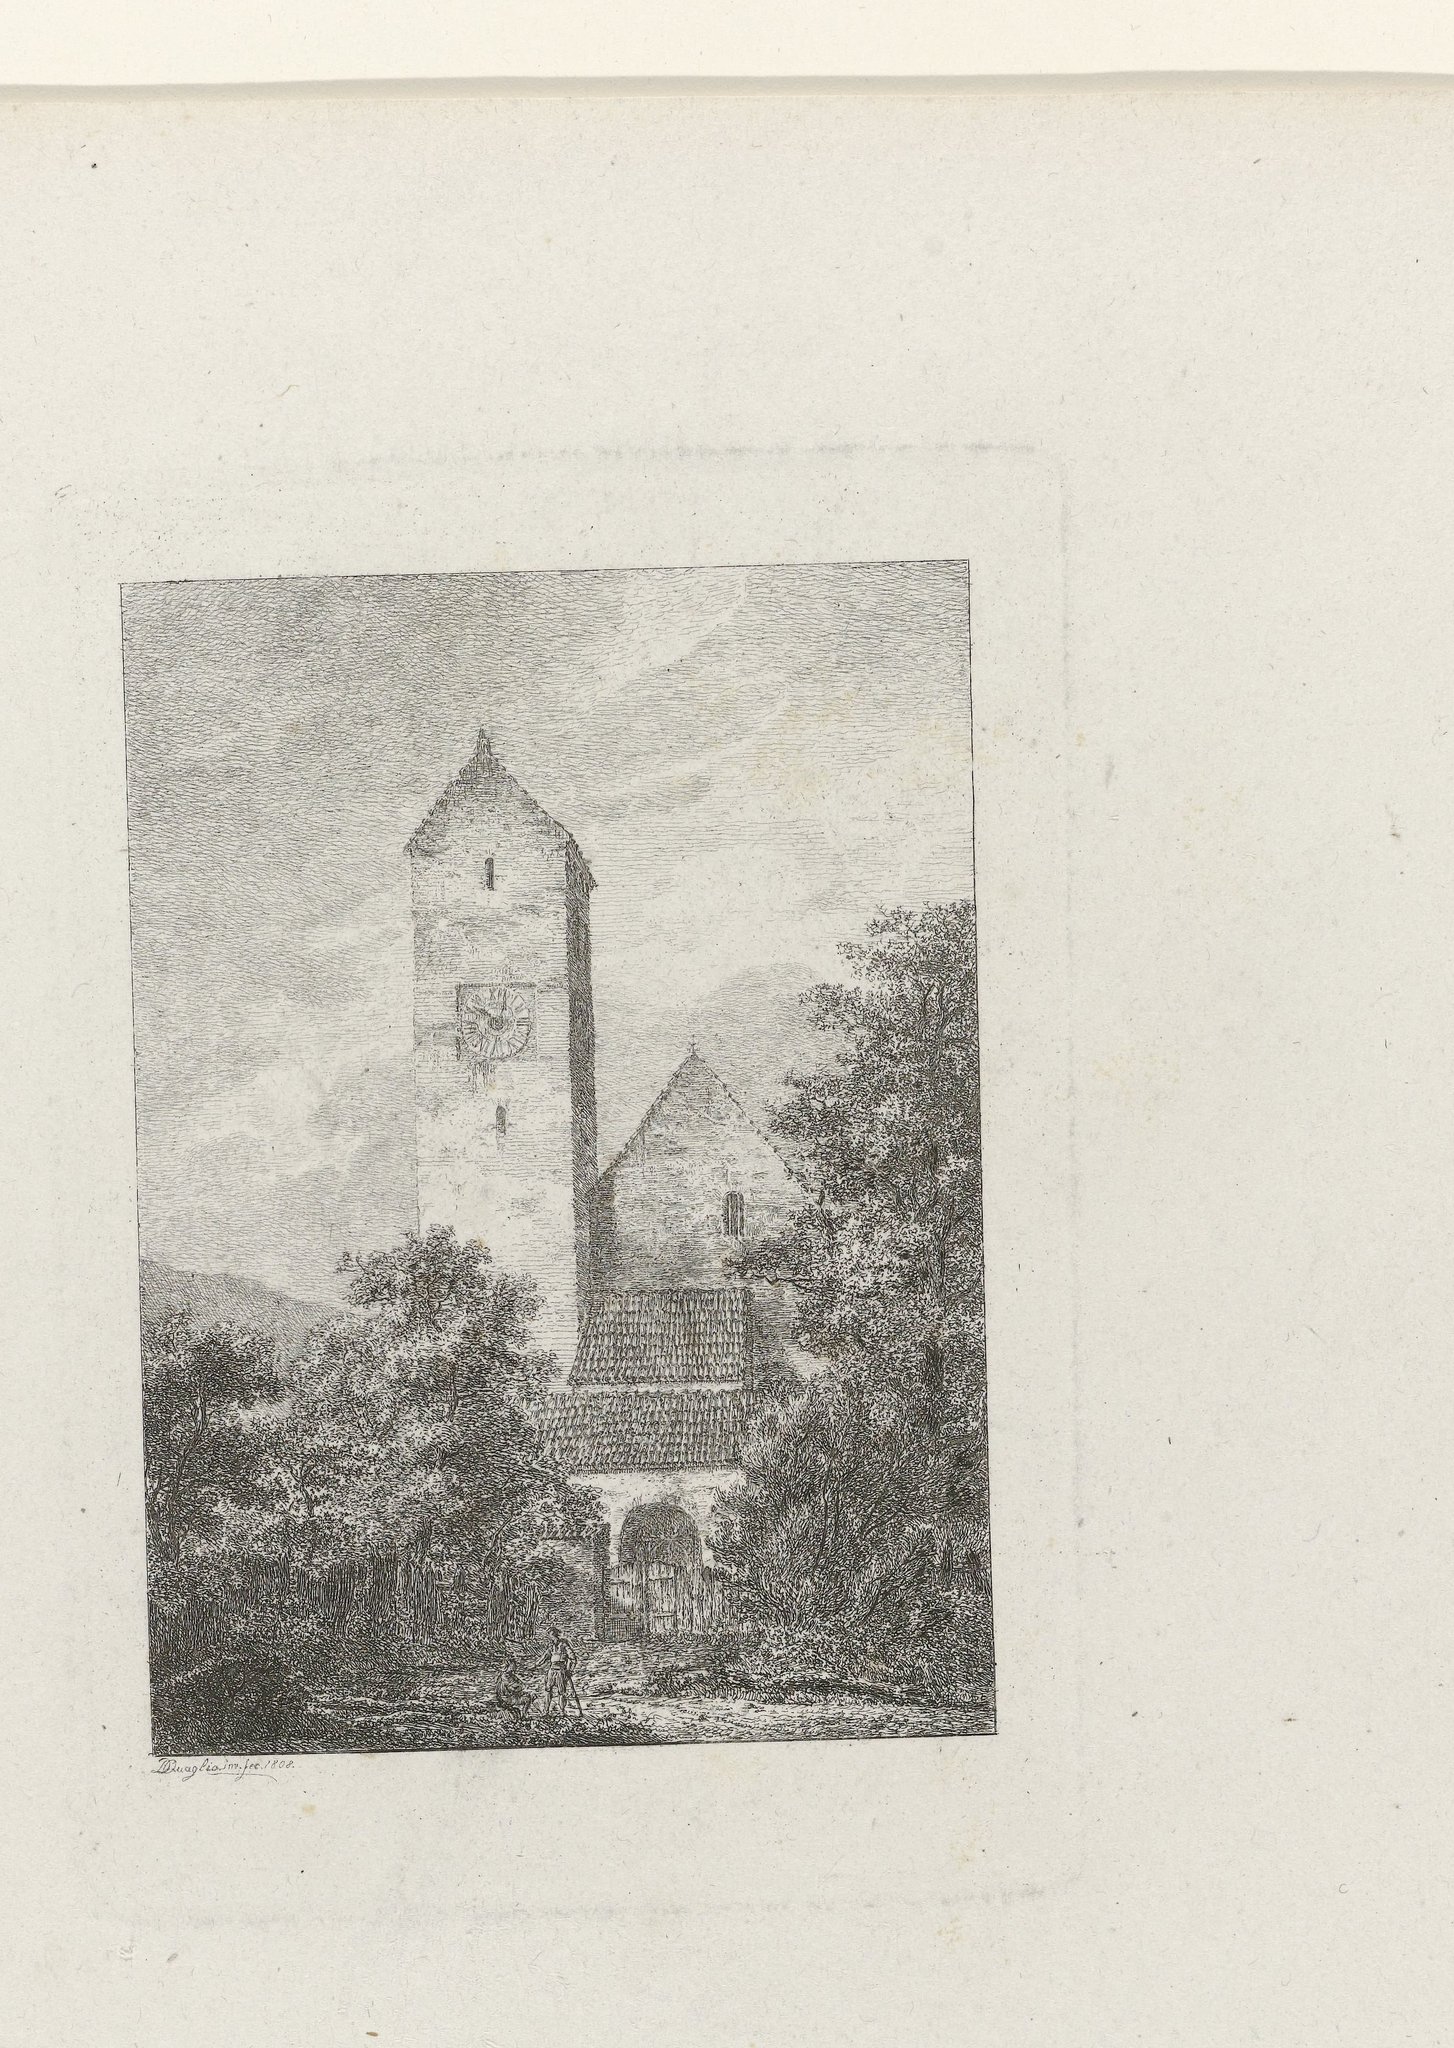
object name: print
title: Vierentwintig landschappen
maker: johann velten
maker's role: print maker, publisher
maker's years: 1784-1864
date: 1808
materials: paper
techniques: etching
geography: karlsruhe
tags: church (exterior), landscapes in the temperate zone (+ landscape with figures, staffage)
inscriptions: collector's mark: Lugt 2760, collector's mark: Lugt 2228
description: Deze prent maakt deel uit van een serie van 24 prenten.